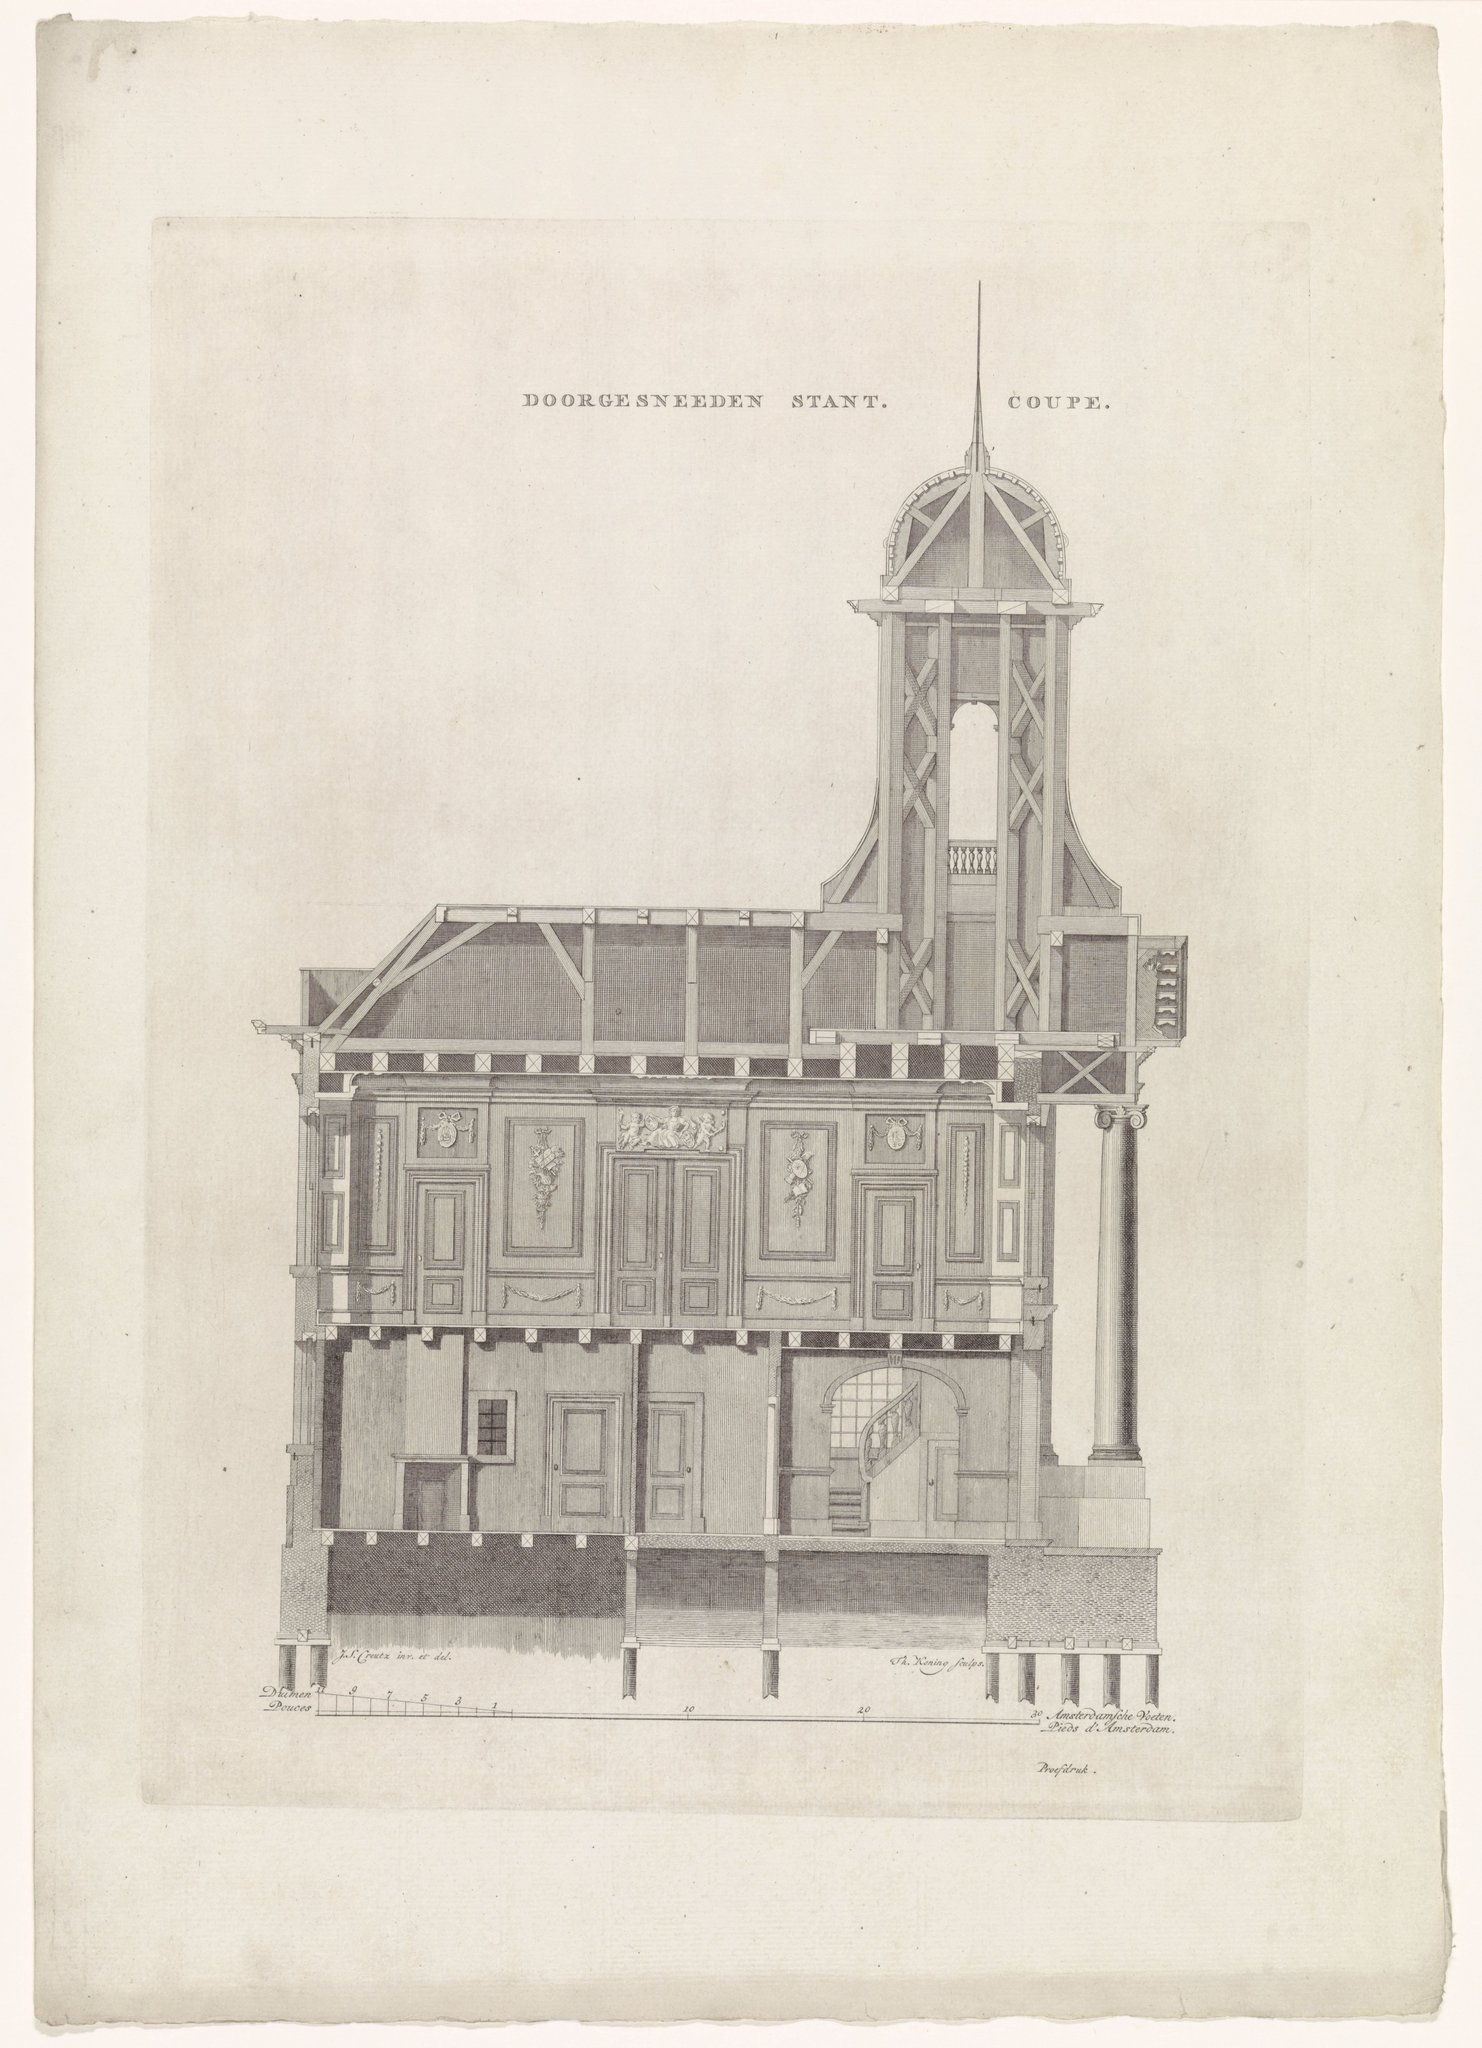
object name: print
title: Doorsnede van de rechtbank te Westzaan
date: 1782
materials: paper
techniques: etching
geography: amsterdam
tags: faith, 'fides'; 'fede', 'fede catholica', 'fede christiana', 'fede christiana catholica' (ripa) ~ one of the three theological virtues, wisdom; 'sapienza', 'sapienza humana', 'sapienza vera' (ripa), section ~ architectural design or model, symbols and allegories of jurisprudence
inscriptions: collector's mark: Lugt 2228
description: Doorsnede van de rechtkamer met trofeeën en allegorieën op de godsdienst, de rechtsgeleerdheid en een deurstuk. Onder de doorsnede een schaalverdeling. De prent maakt deel uit van een serie met tien afbeeldingen van de rechtbank te Westzaan.